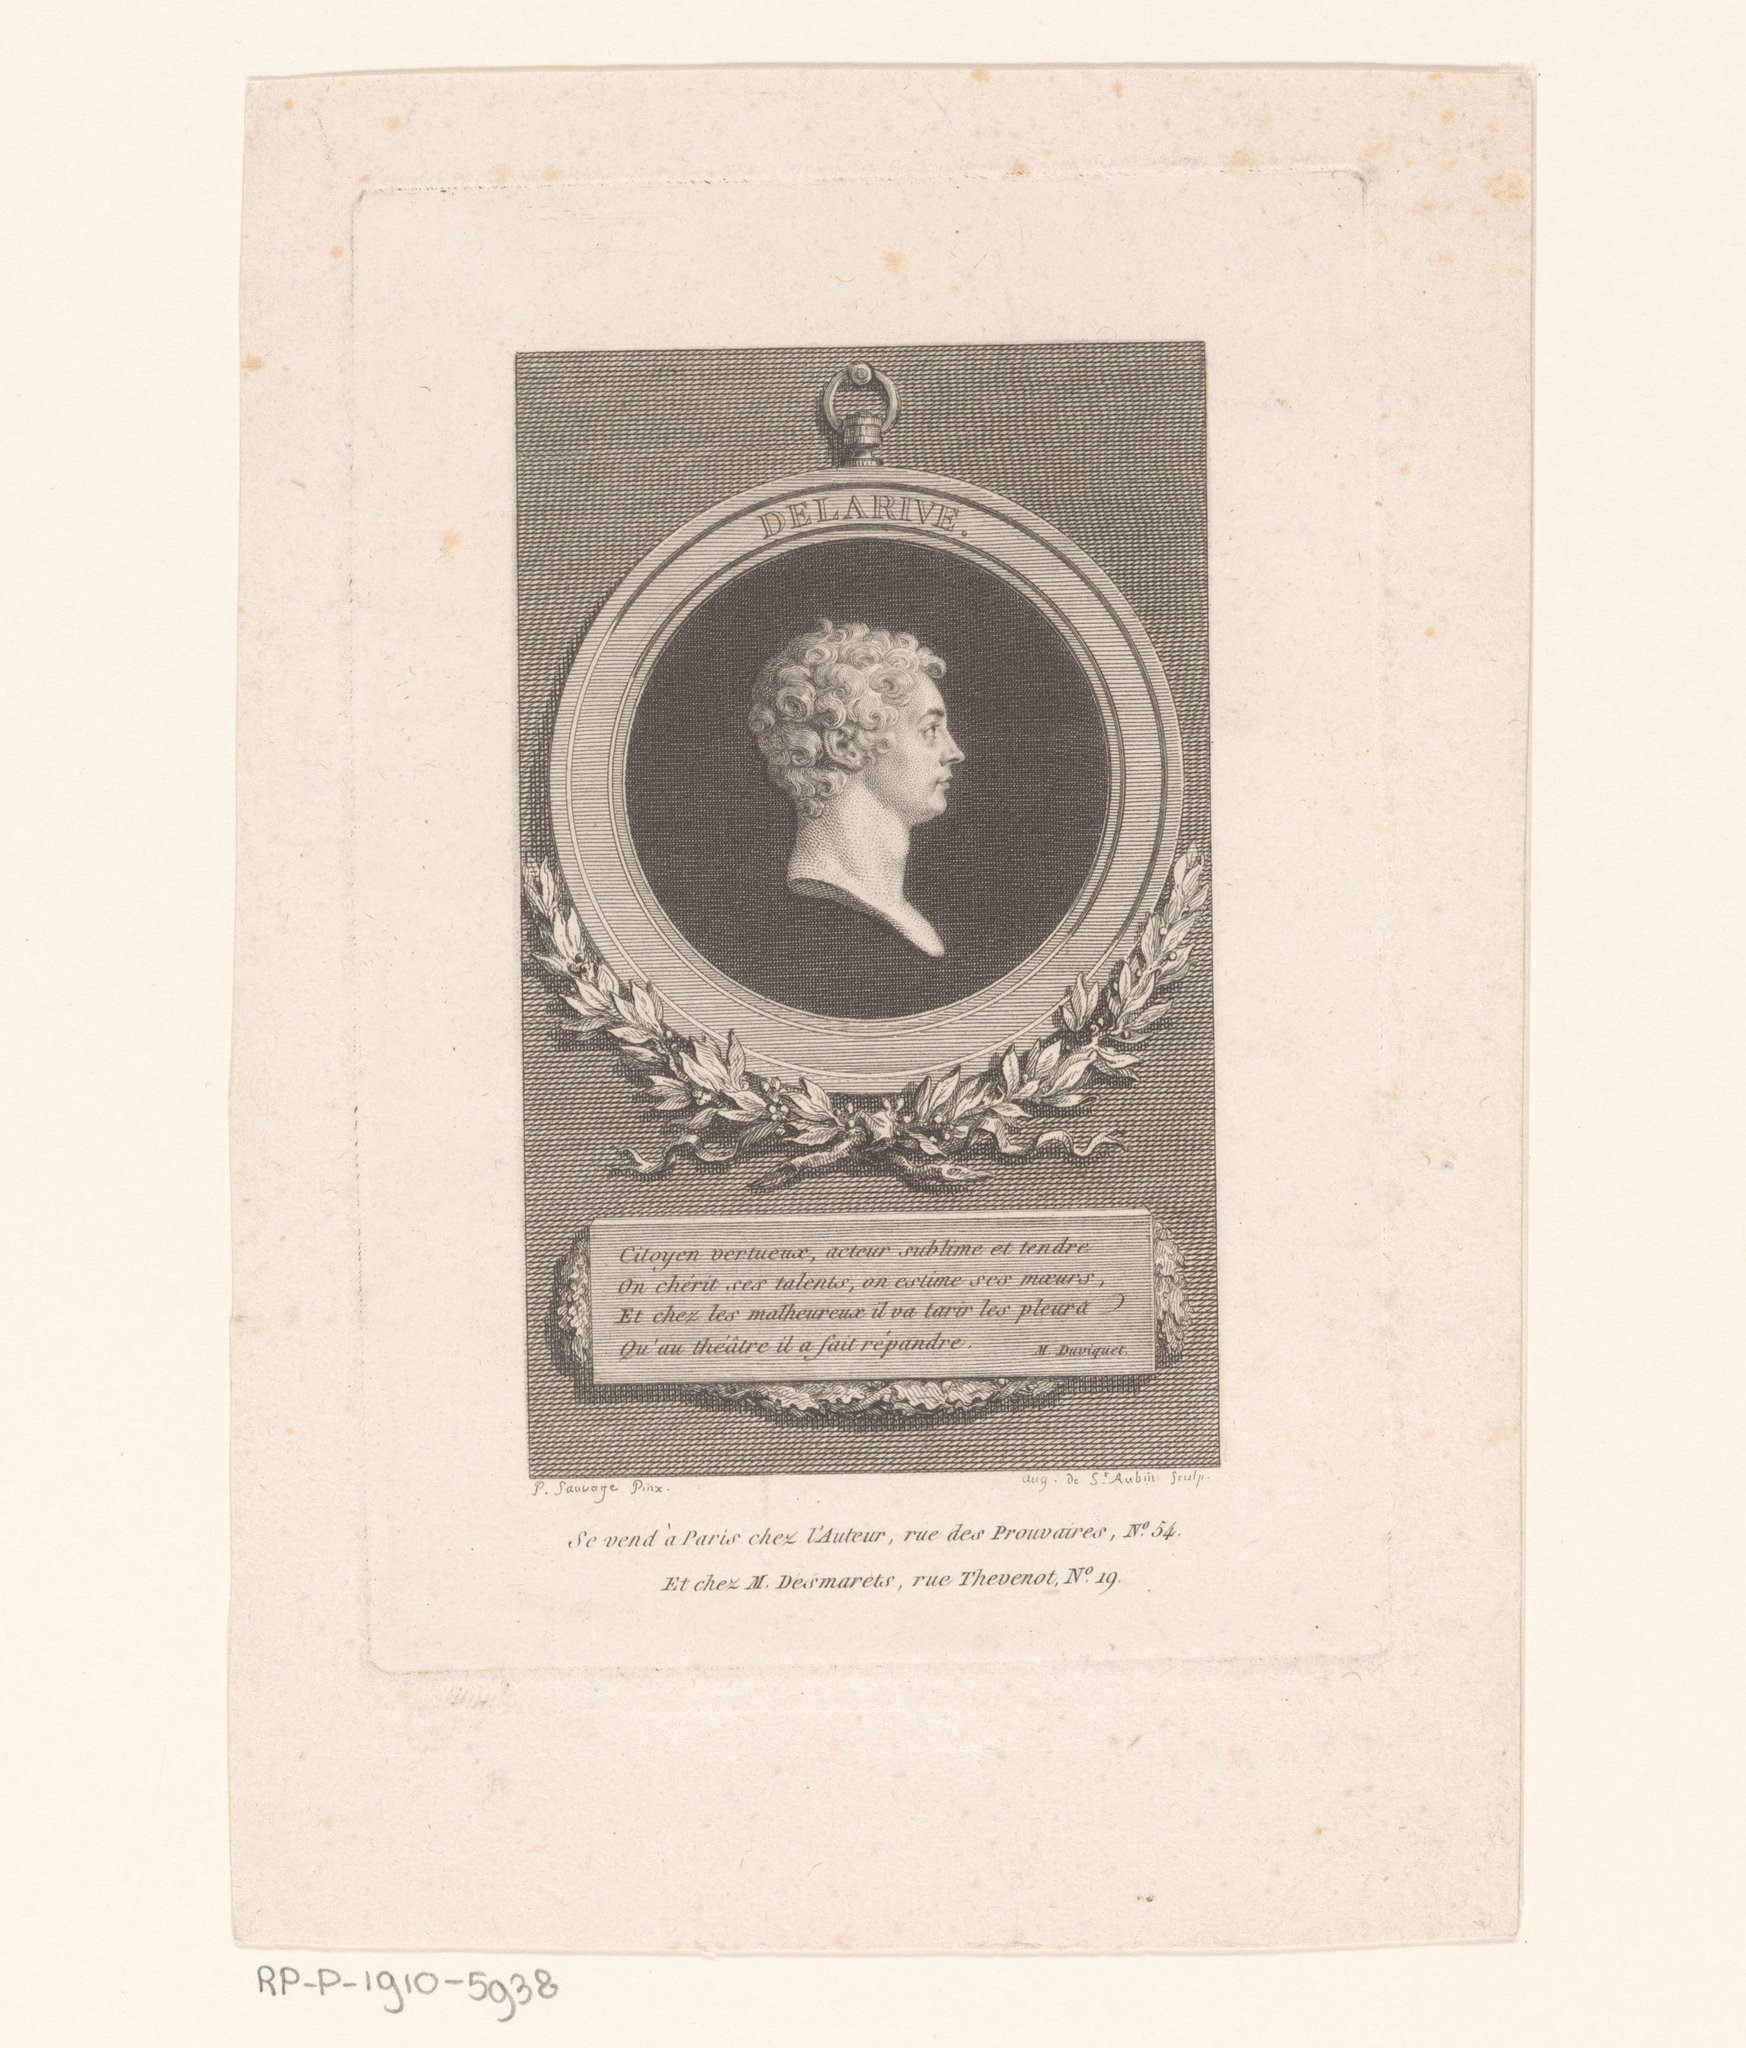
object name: print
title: Portret van Larive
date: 1746-1807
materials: paper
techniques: engraving, etching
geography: paris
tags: historical persons, portrait of actor, actress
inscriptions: collector's mark: Lugt 2228